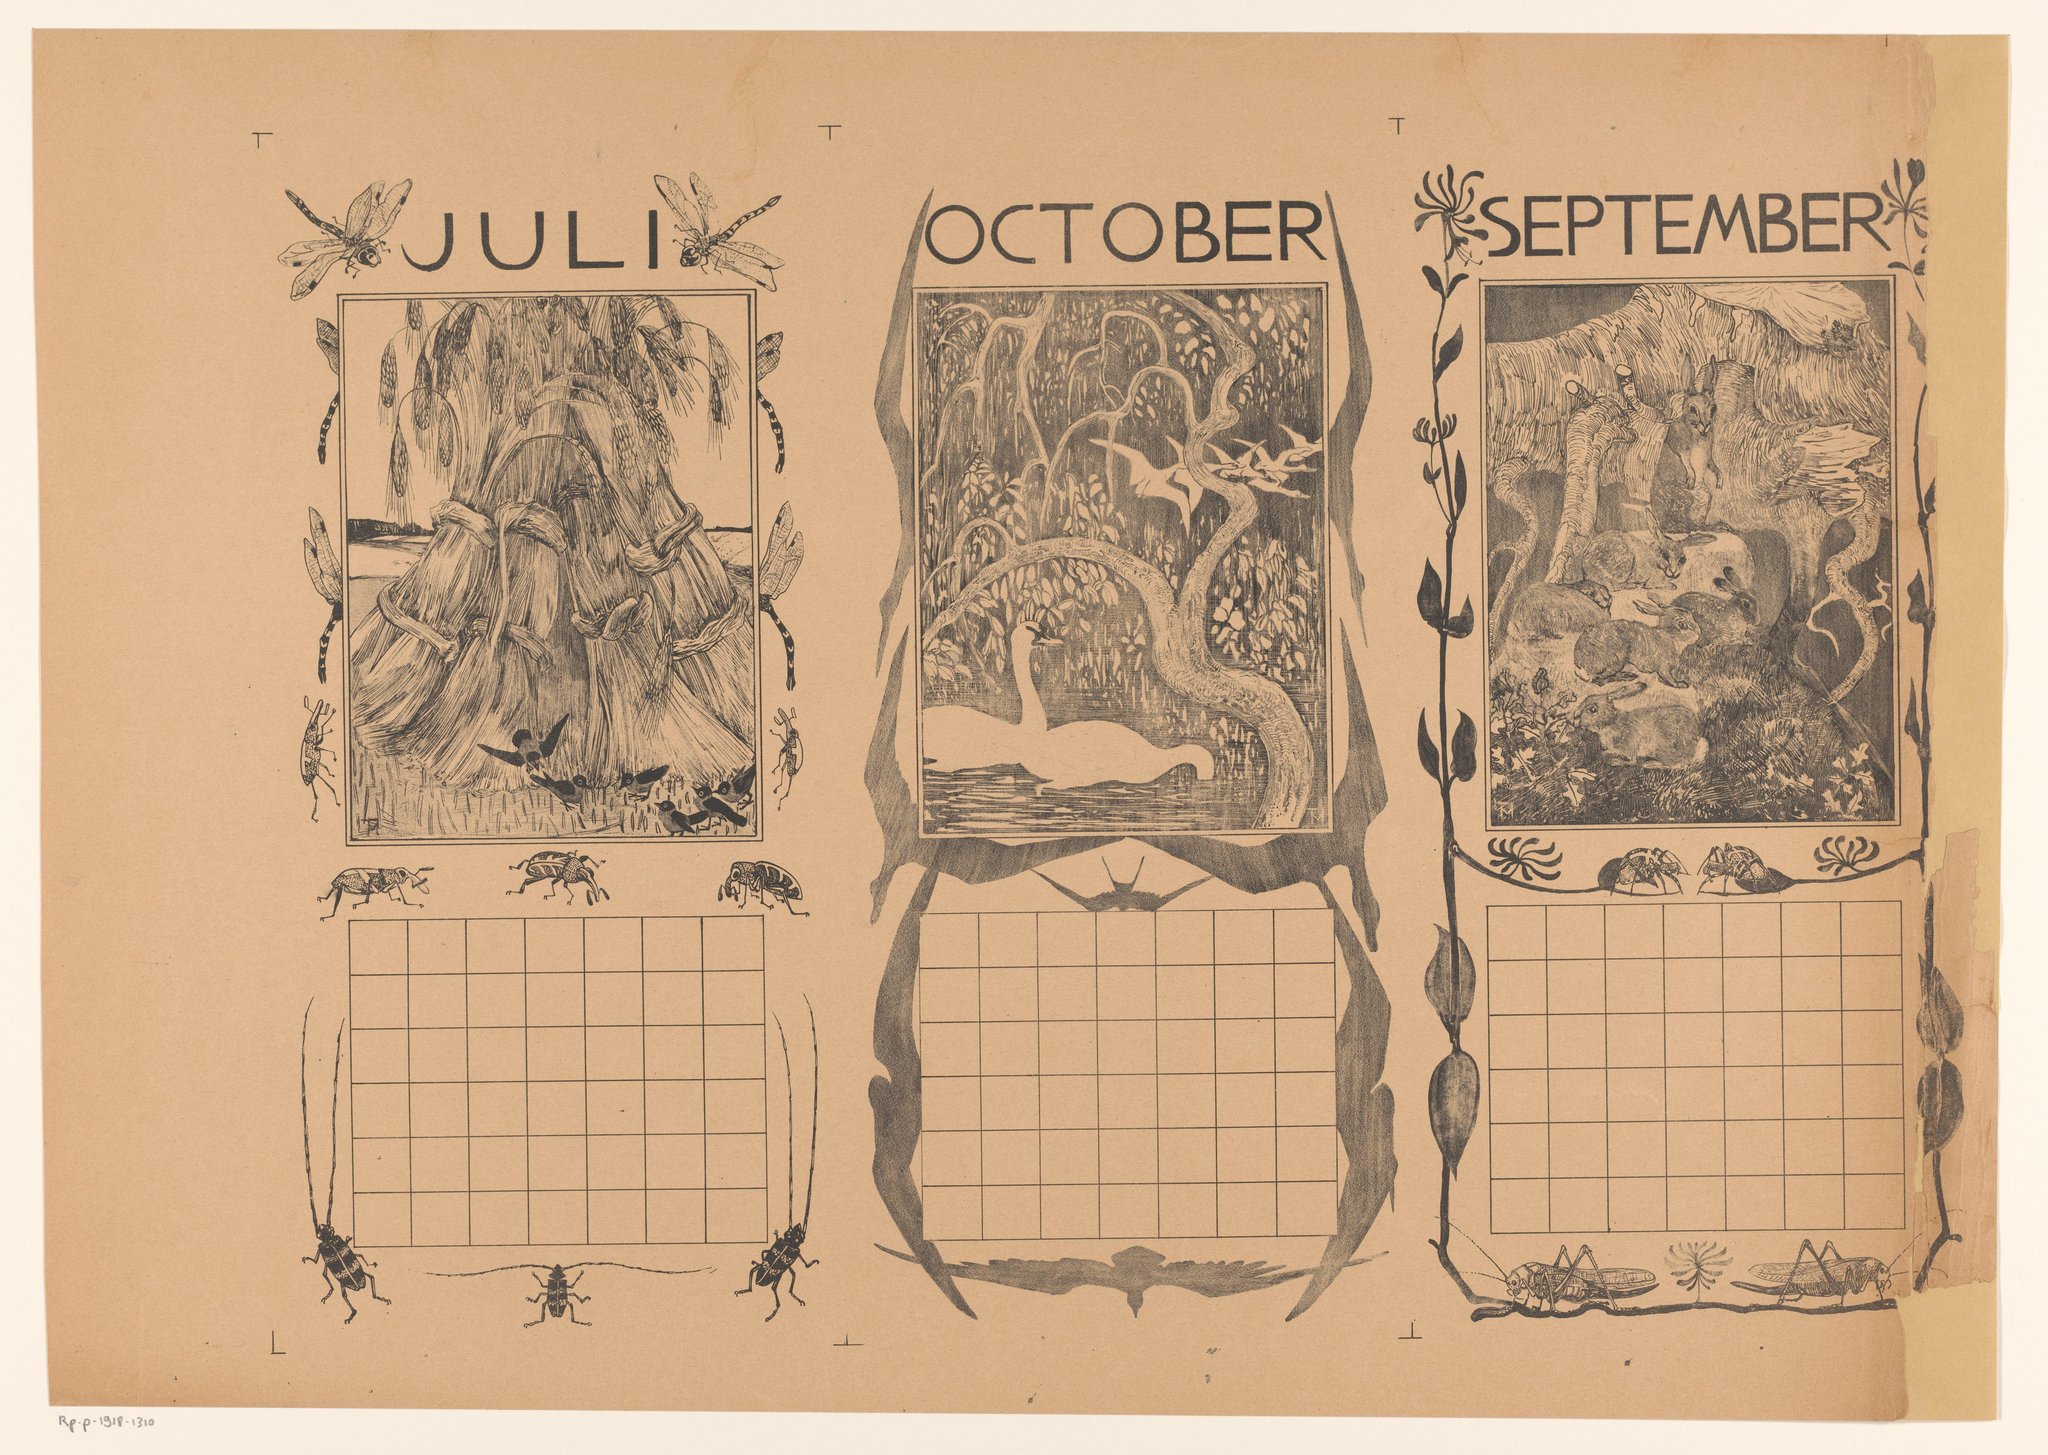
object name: print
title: Kalenderbladen van juli, oktober en september, met korenschoven, zwanen en konijnen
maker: theo van hoytema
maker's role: draughtsman, painter, print maker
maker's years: 1863-1917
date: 1901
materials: paper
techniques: lithograph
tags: plants and herbs: wheat, calendar, almanac, water-birds: swan, rodents: rabbit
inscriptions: collector's mark: Lugt 2233